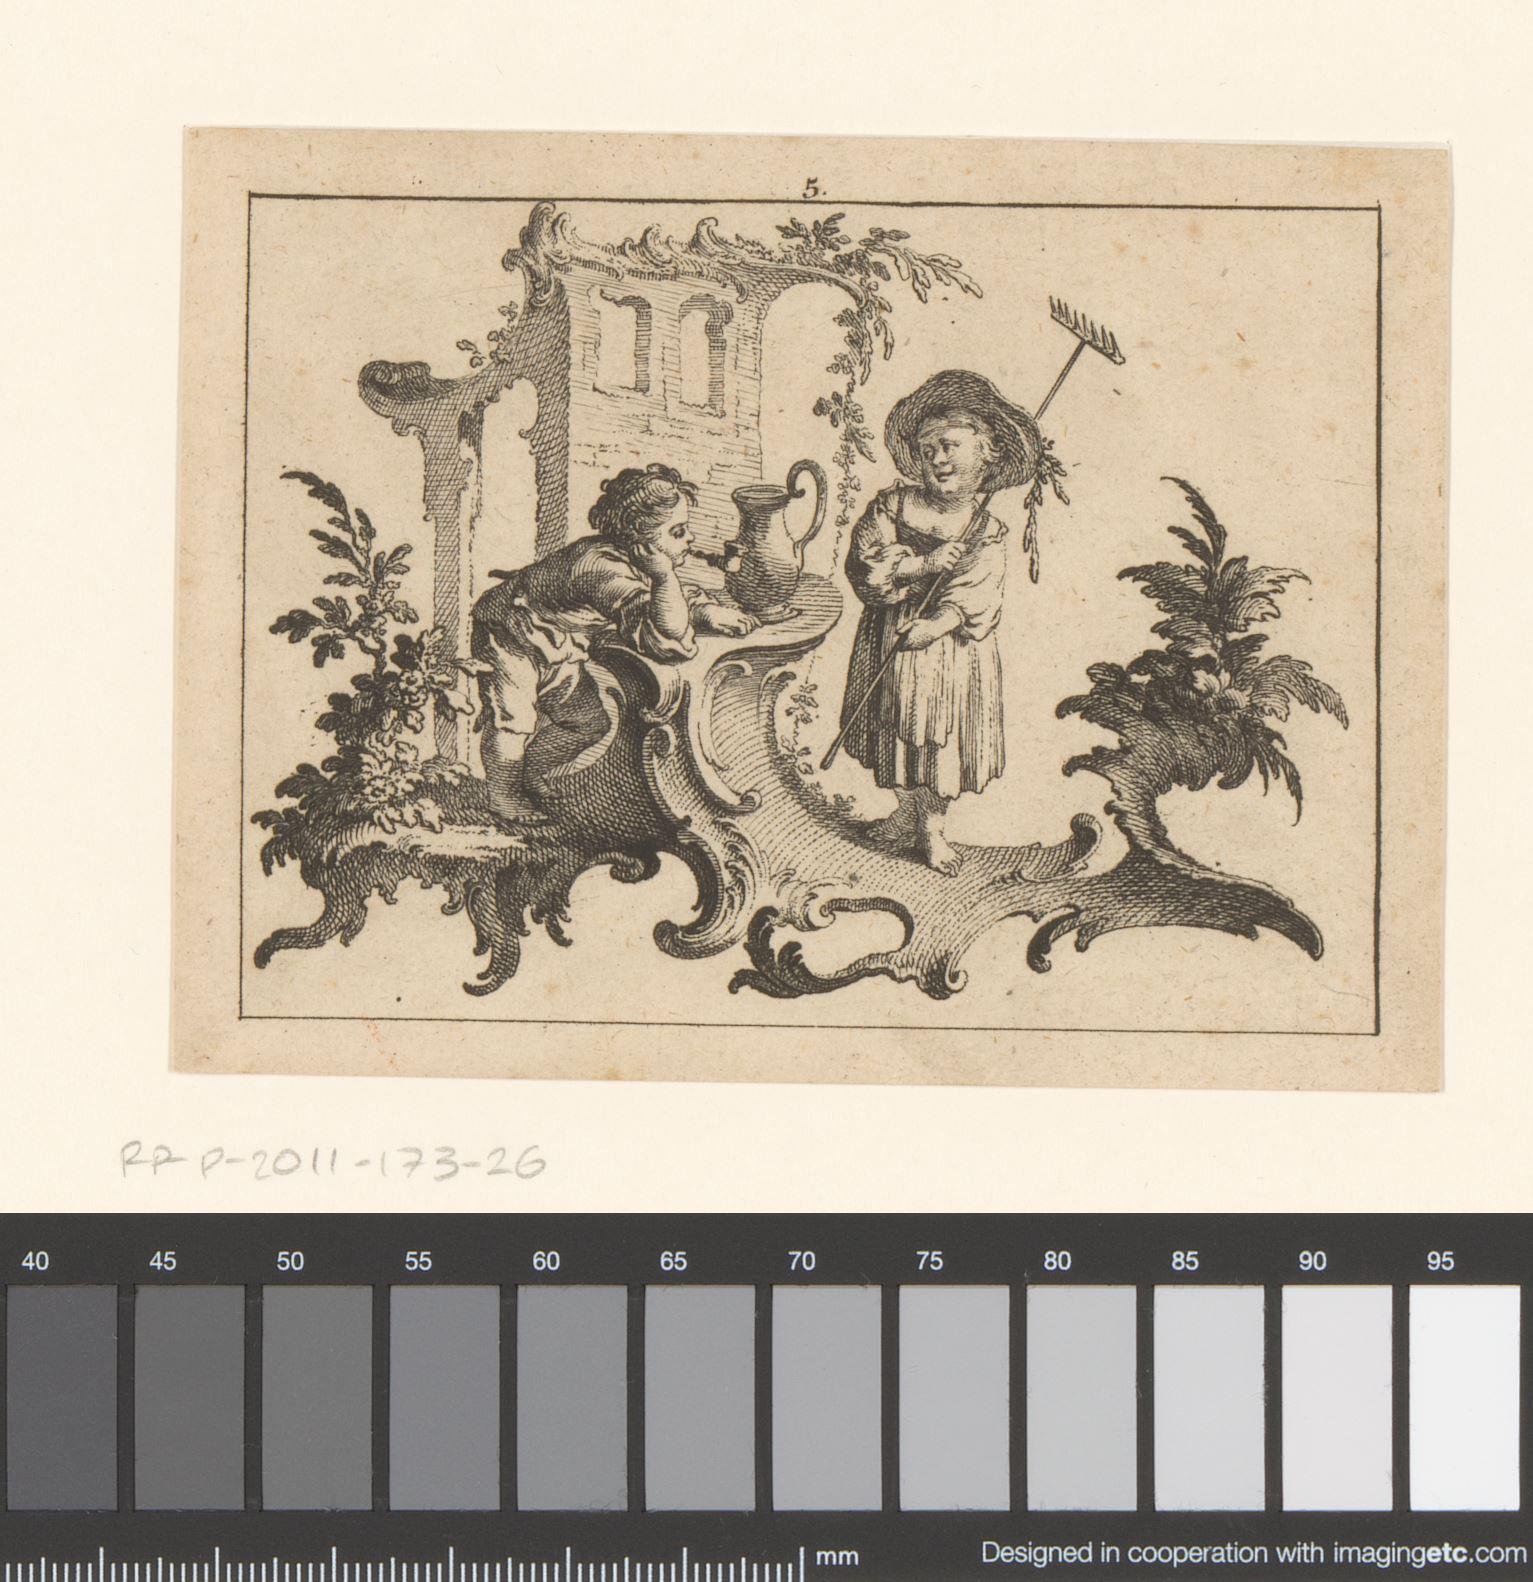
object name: ornament print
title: Rokers op rococo-ornament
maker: johann esaias nilson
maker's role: draughtsman, print maker, publisher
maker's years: 1721-1788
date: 1731-1788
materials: paper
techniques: engraving, etching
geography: augsburg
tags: pipe ~ tobacco, gardening-tools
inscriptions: collector's mark: Lugt 2760, collector's mark: Lugt 2228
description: Na de overname van de firma Niemeyer door British American Tabacco Group besloot deze de collectie van het Niemeyer Tabaksmuseum af te stoten. De beheerder van de collectie, het Noordelijk Scheepvaartmuseum, organiseerde in januari 2011 open dagen voor musea waar deze hun voorkeuren voor collectieonderdelen kenbaar konden maken. De objecten zijn getaxeerd door medewerkers van Christie's en vervolgens ter overname aangeboden aan de belangstellende musea. Het Rijksprentenkabinet koos 46 prenten uit de collectie tegen door de medewerkers van Christie's vastgestelde waarde. [H. Leeflang, 2011-06-09]. Nummer 1-4, 3-8 en 9-12 komen van één plaat.